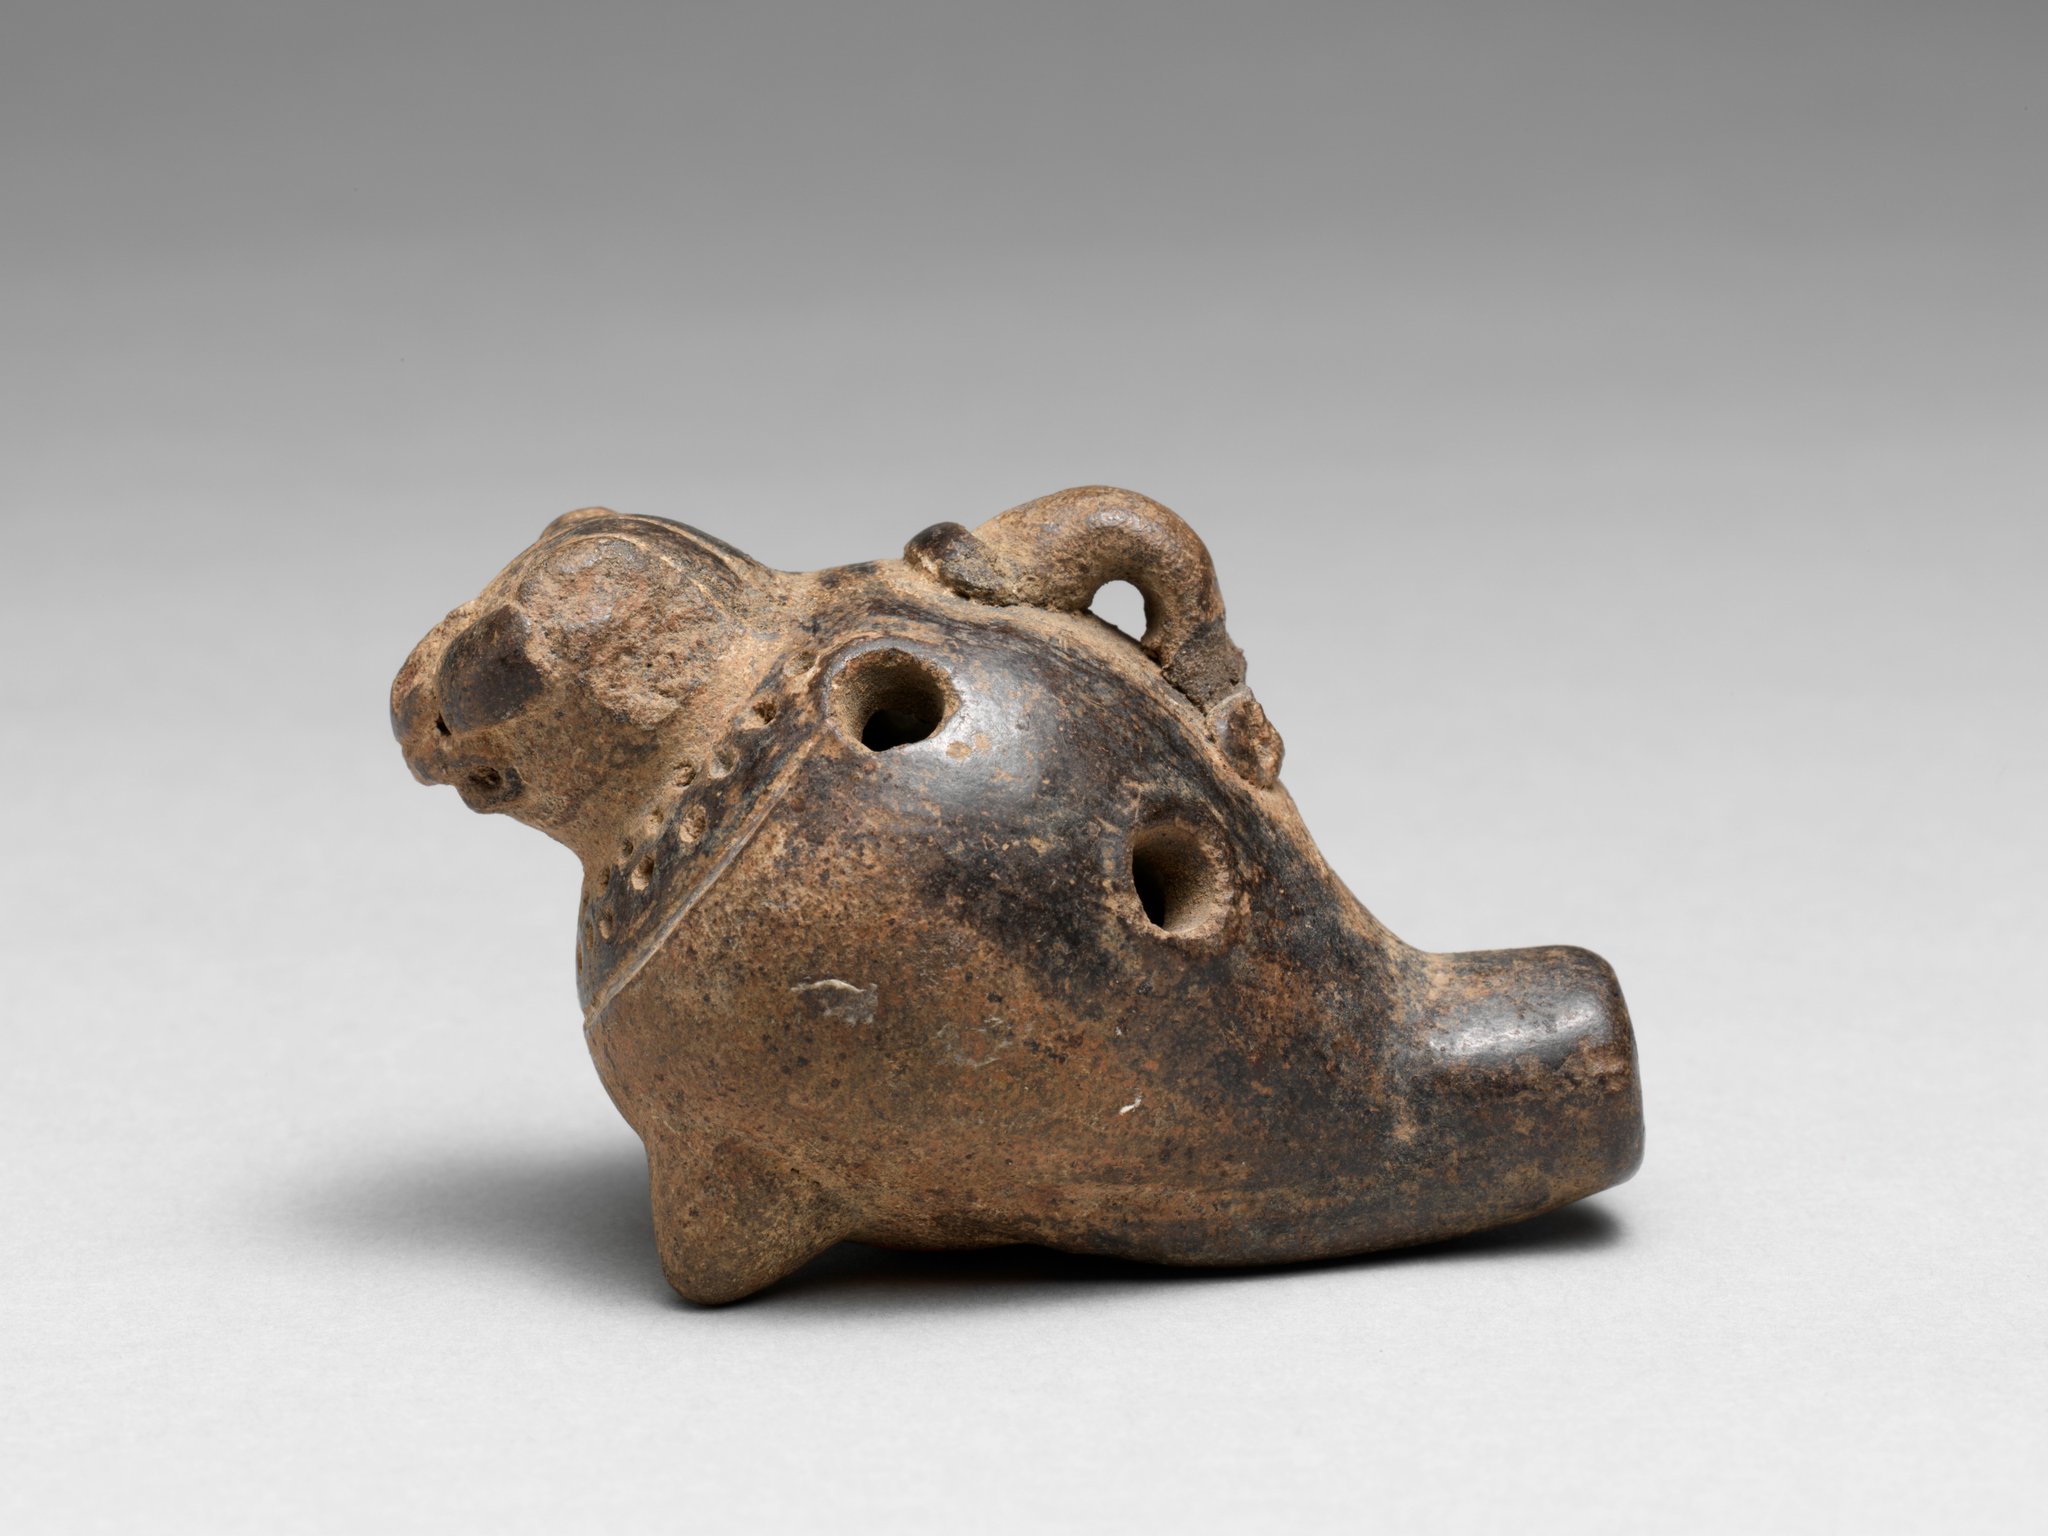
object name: pottery whistle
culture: costa rican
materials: clay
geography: costa rica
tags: animals